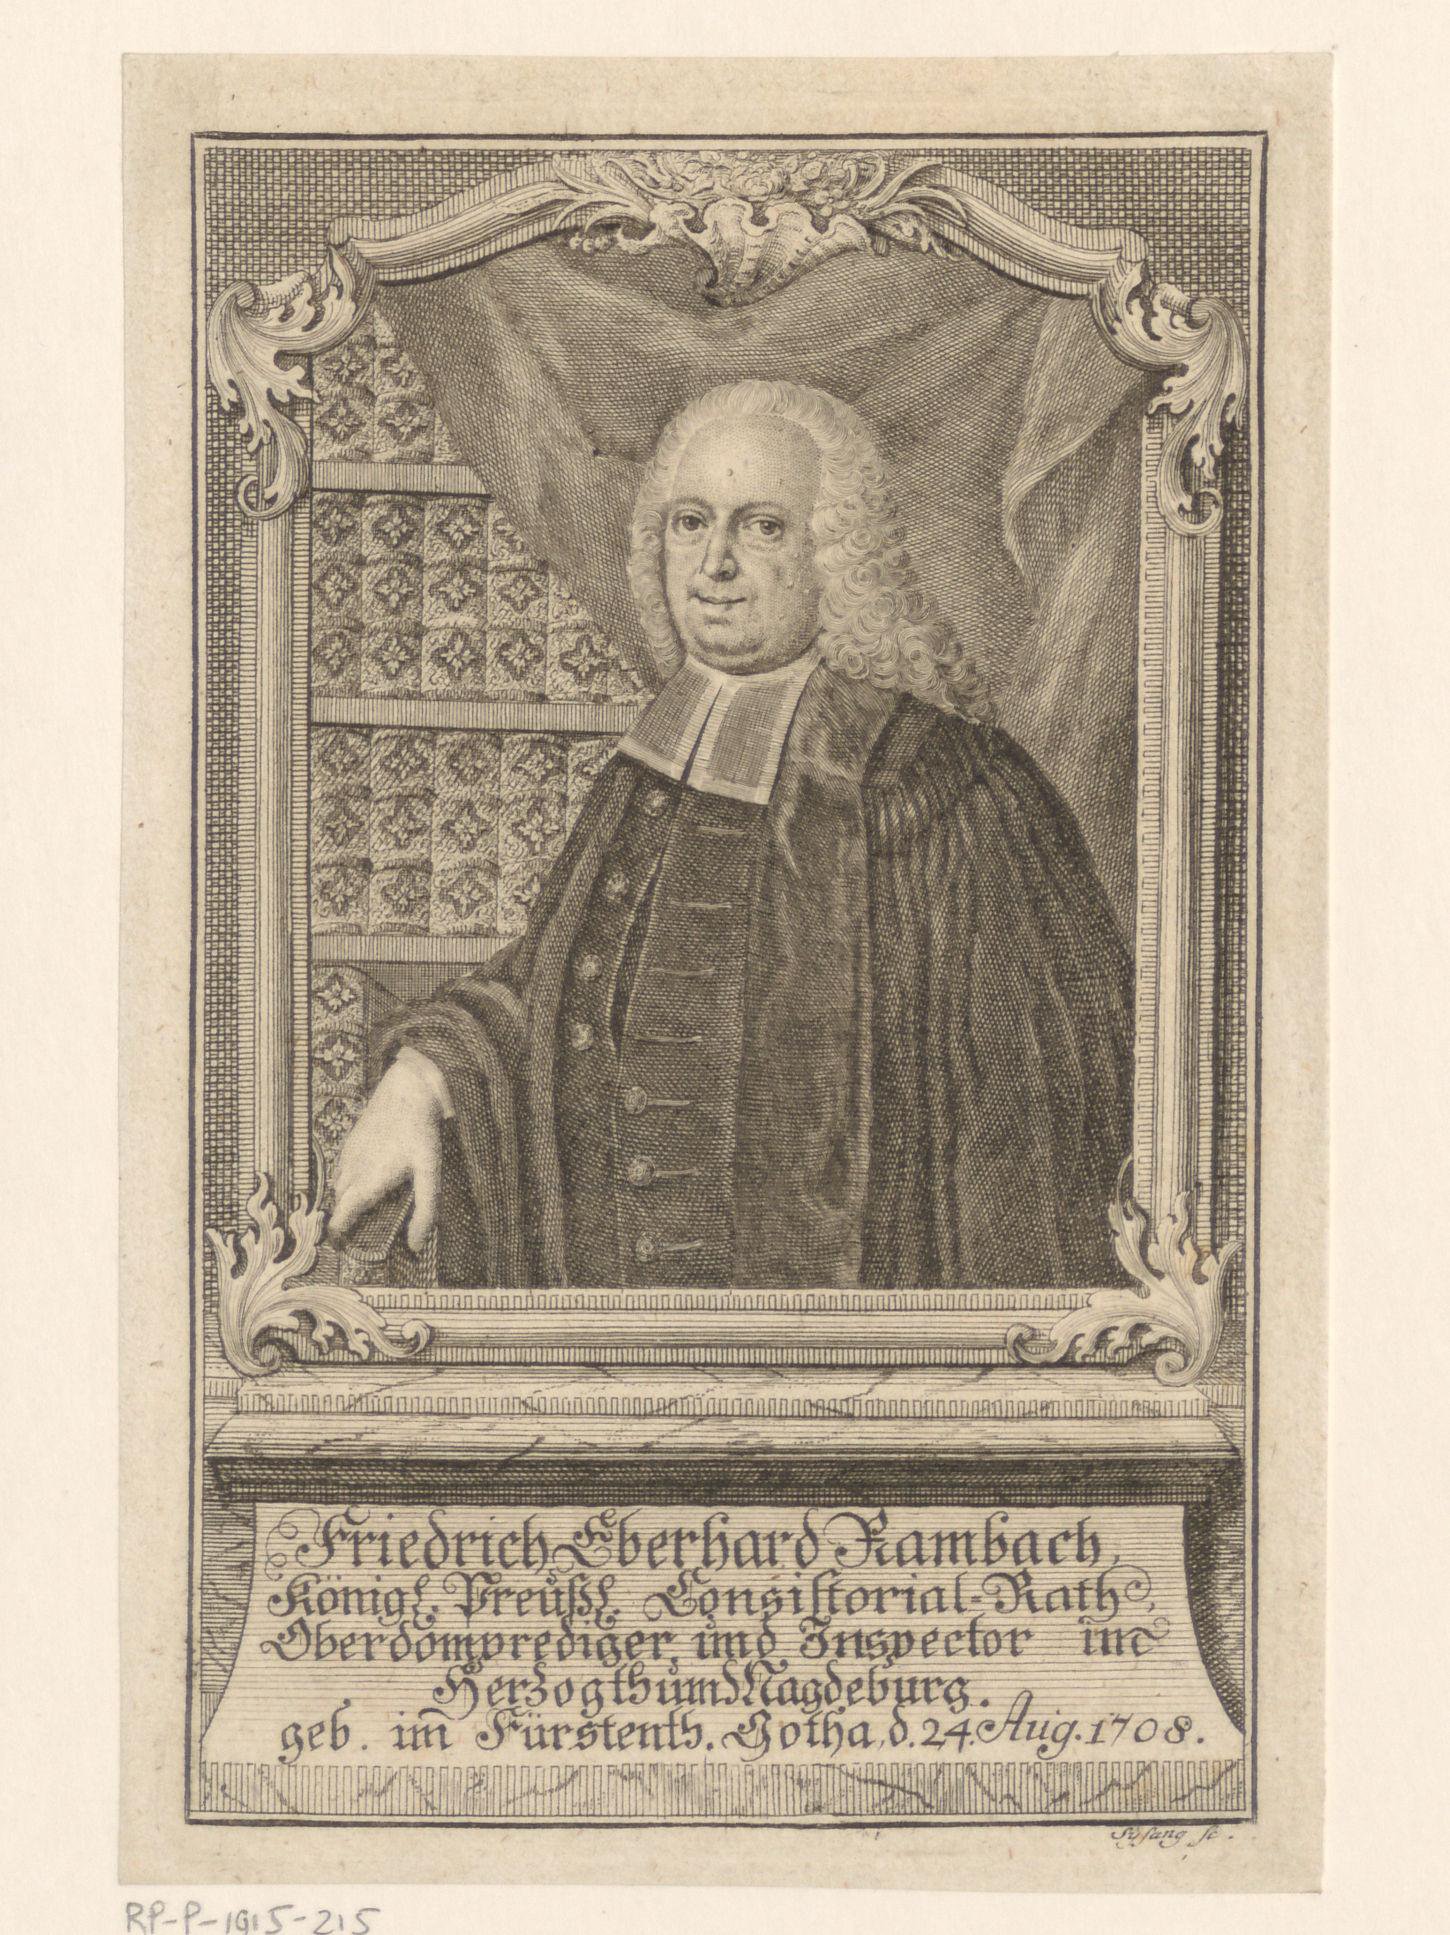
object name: print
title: Portret van Friedrich Eberhard Rambach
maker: johann christoph sysang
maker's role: print maker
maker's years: 1703-1757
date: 1750-1757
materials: paper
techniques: engraving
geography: leipzig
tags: bookshelves, historical persons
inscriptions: collector's mark: Lugt 2228